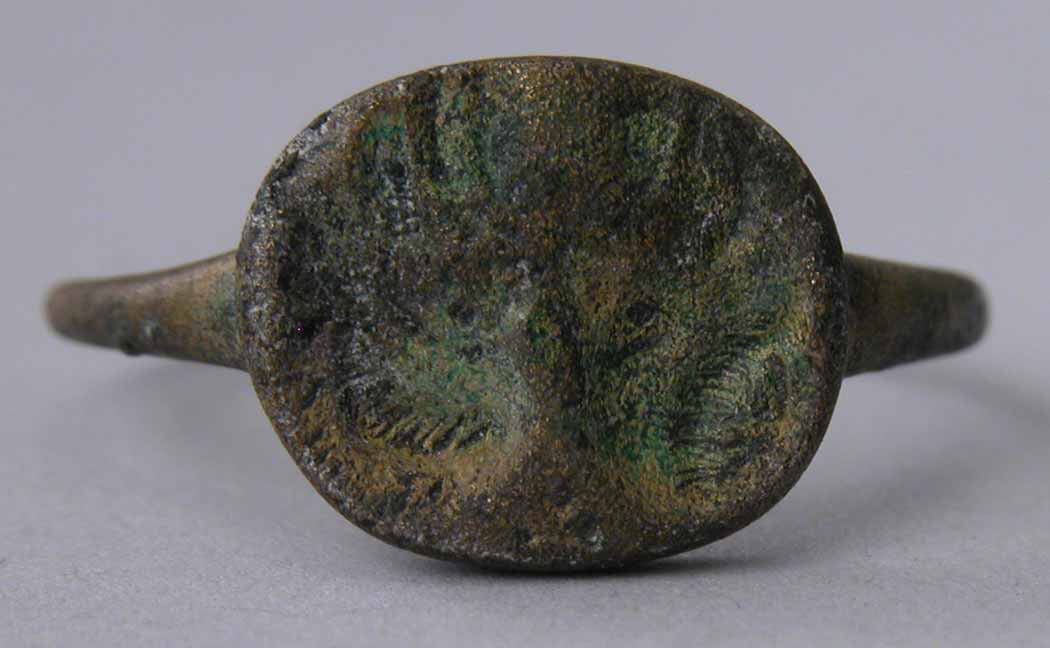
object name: ring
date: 201-1200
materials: bronze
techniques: gilding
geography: egypt